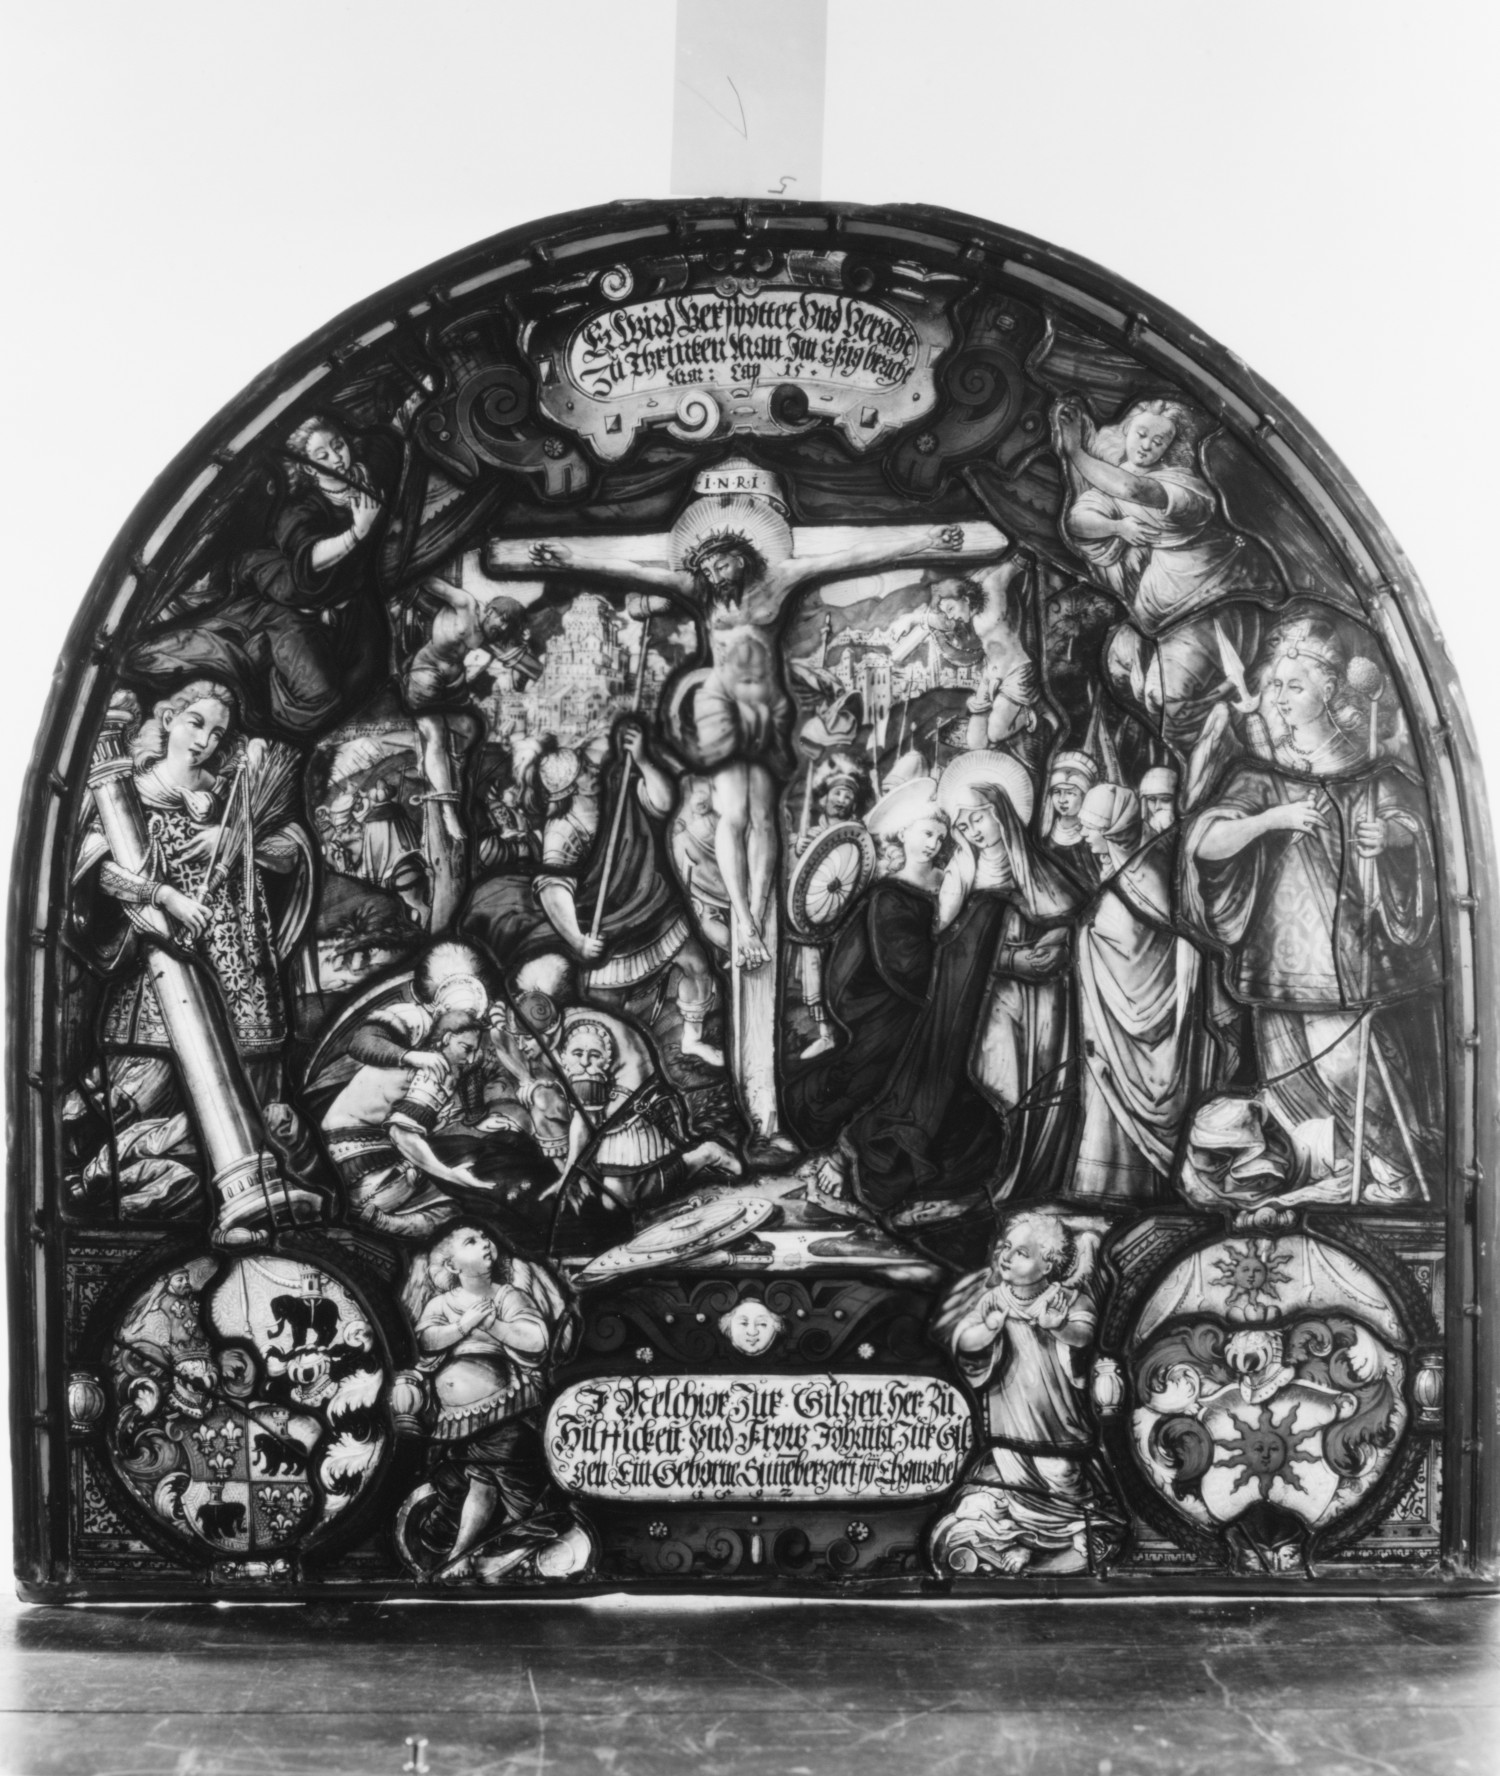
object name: panel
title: The Crucifixion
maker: franz fallenter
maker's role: artist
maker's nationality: german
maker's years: 1550-1616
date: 1592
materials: glass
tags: women,angels,christ,crucifixion